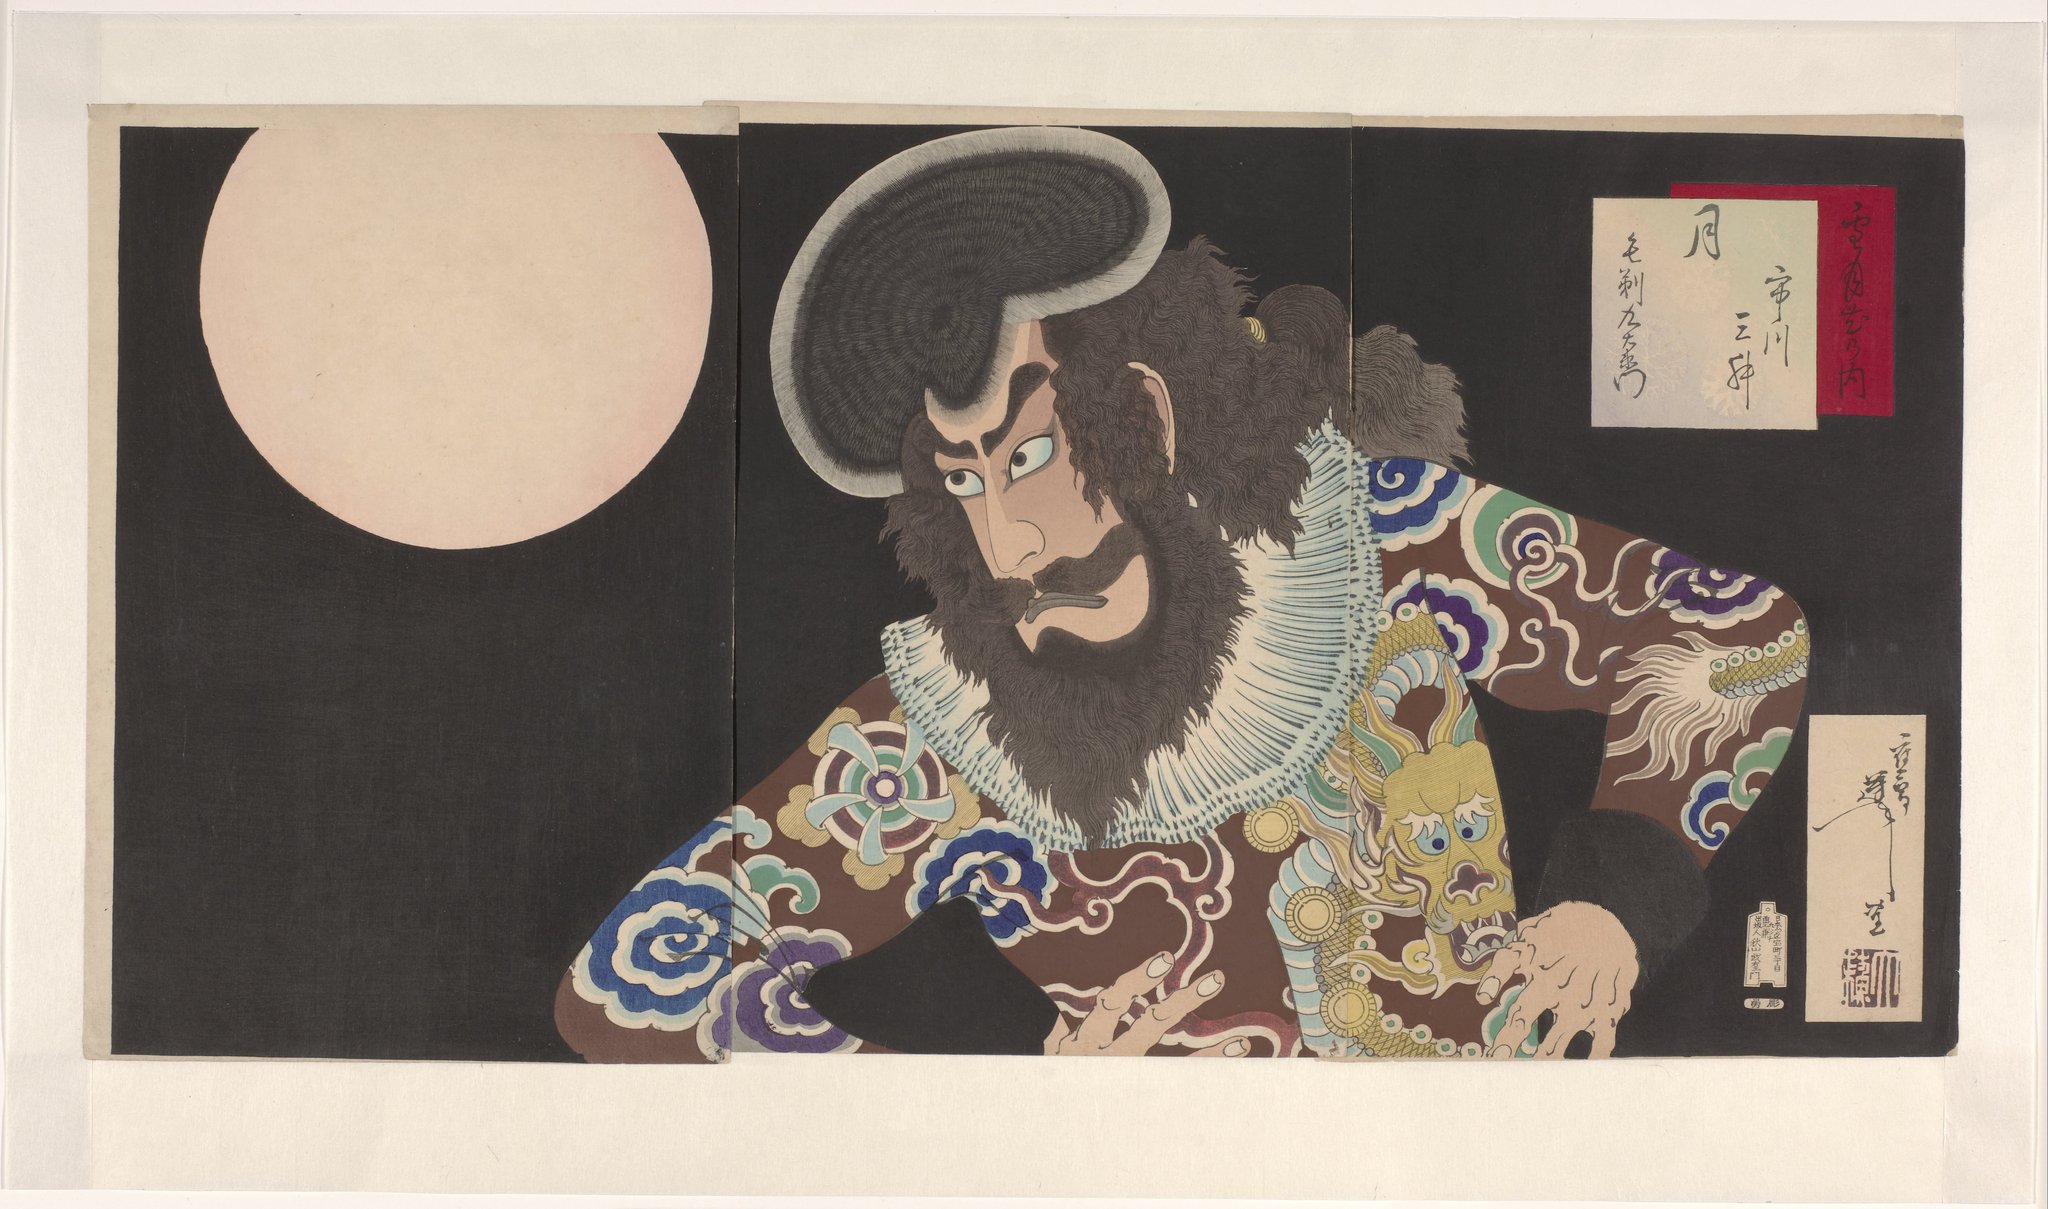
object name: print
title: Ichikawa Danjuro IX als Kezori Kuemon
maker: tsukioka yoshitoshi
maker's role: print maker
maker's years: 1839-1892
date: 1890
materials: paper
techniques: woodcut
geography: edo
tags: pirate, corsair, buccaneer, full moon, actor (on the stage)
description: Horizontaal triptiek met Ichikawa Danjuro IX in de rol van de piraat Kezori Kuemon kijkend naar de volle maan.